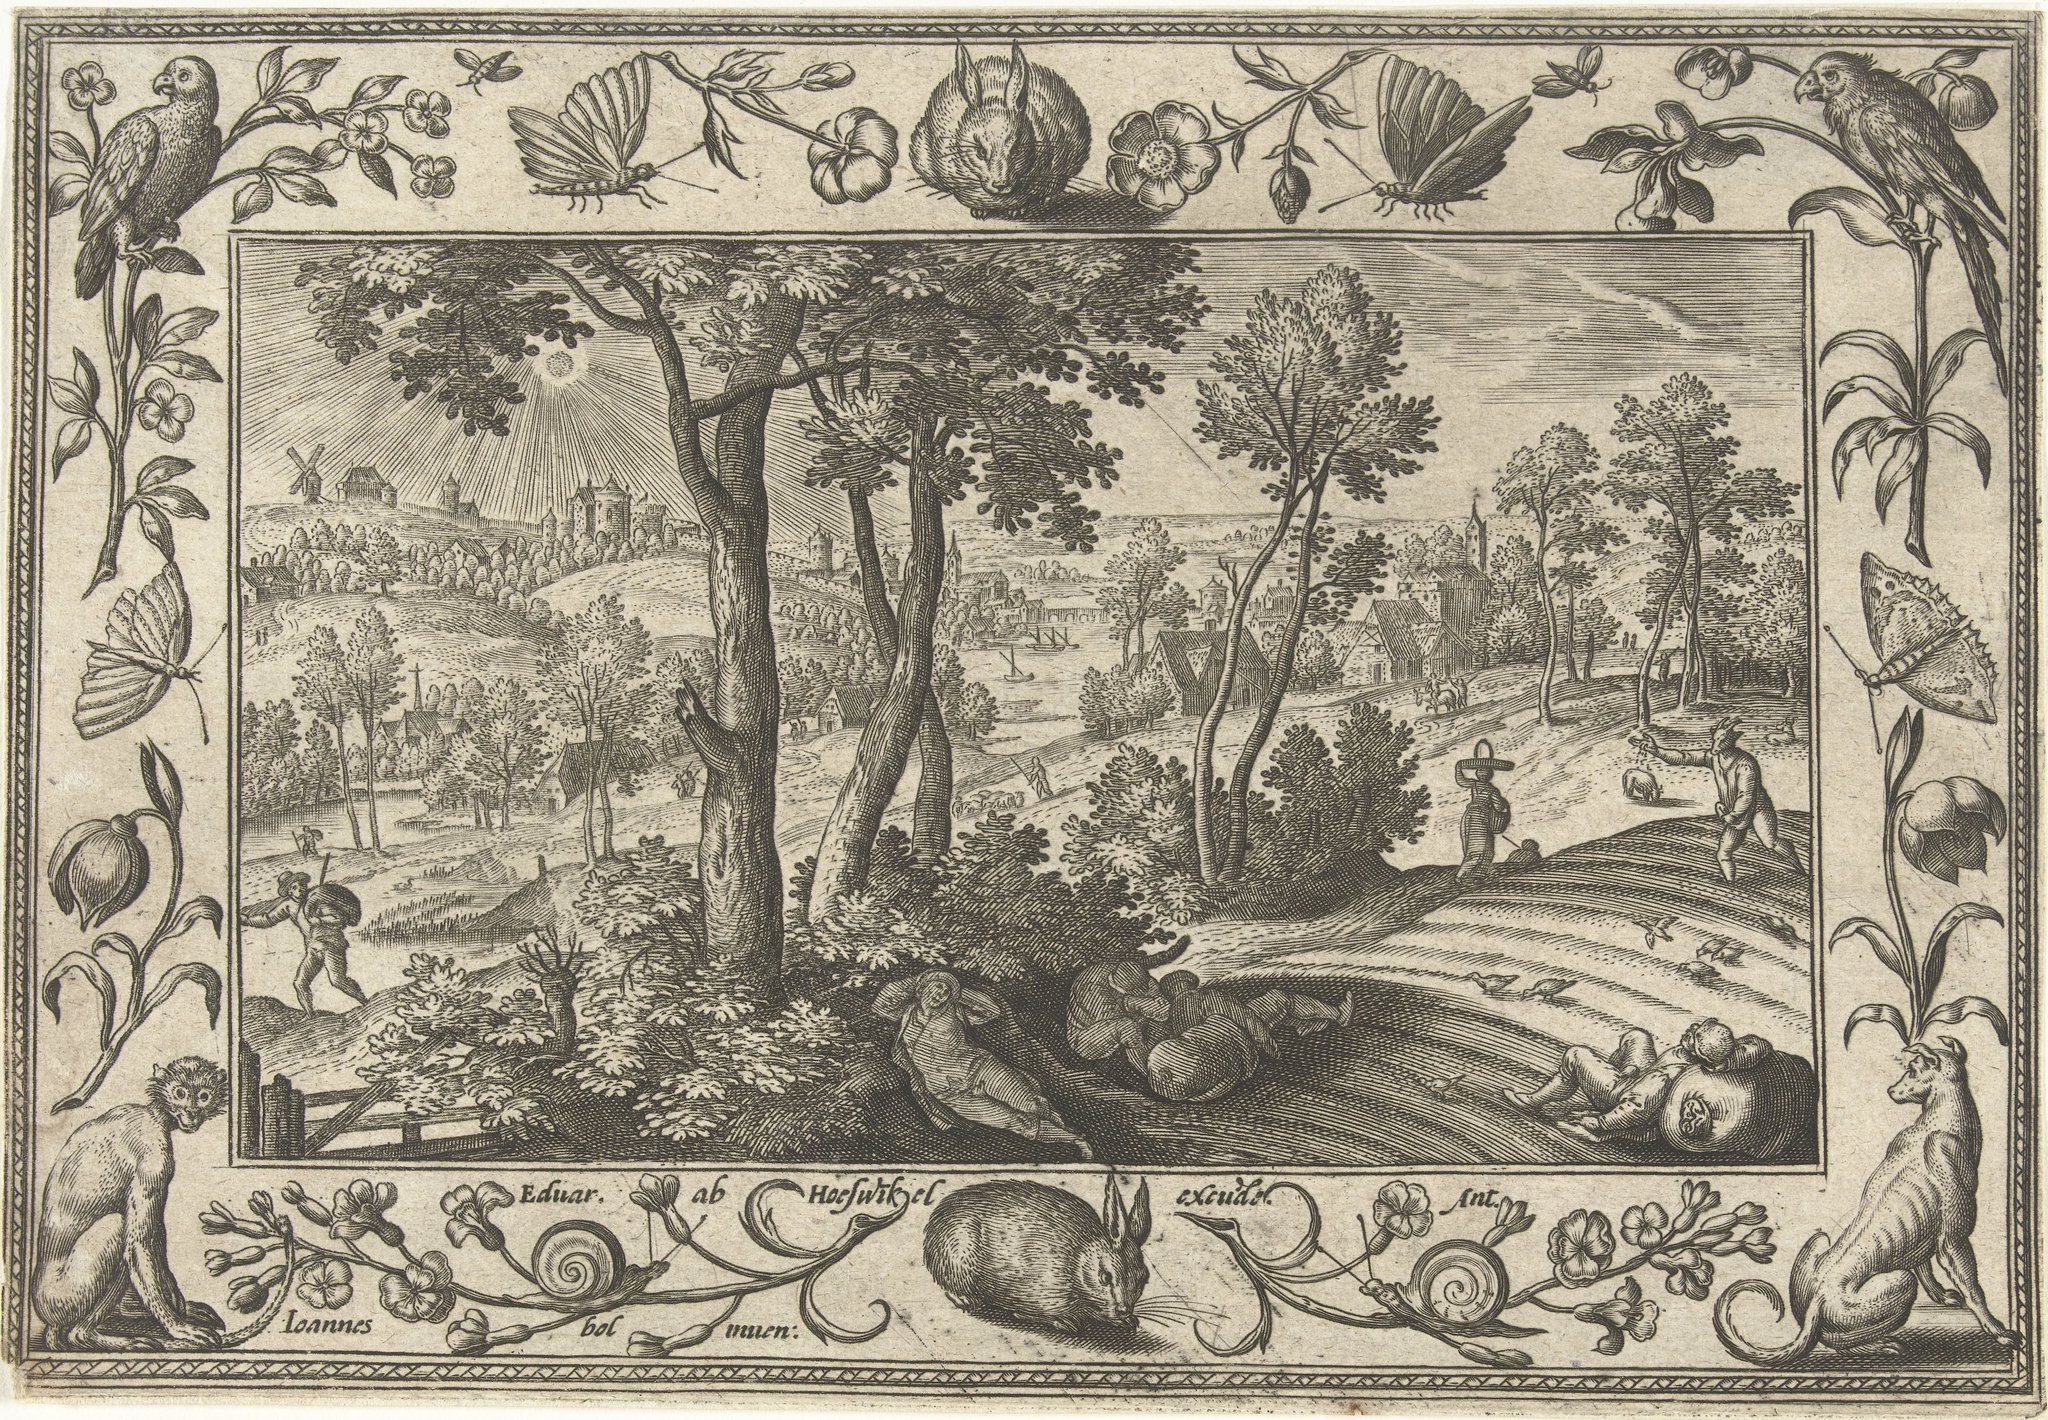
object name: print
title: Landschappen met Bijbelse, mythologische scènes en jachttaferelen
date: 1582-1586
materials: paper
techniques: engraving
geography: antwerp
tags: ornamental birds, cultivated land, while the sower and his servants slept, his enemy (the devil) sowed tares among the wheat, rodents: rabbit (+ ornamental variants of animals), monkeys, apes (+ ornamental variants of animals), dog (+ ornamental variants of animals), flowers ~ ornament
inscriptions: collector's mark: Lugt 2228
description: Landschap met akker en de uitbeelding van de parabel van Christus over het onkruid tussen het tarwe. Op de voorgrond slapen enkele boeren. De duivel zaait ondertussen onkruid tussen het graan. De prent heeft een ornamentele lijst met bloemen en dieren. Hij maakt deel uit van een vierentwintigdelige serie van landschappen met Bijbelse, mythologische scènes en jachttaferelen.